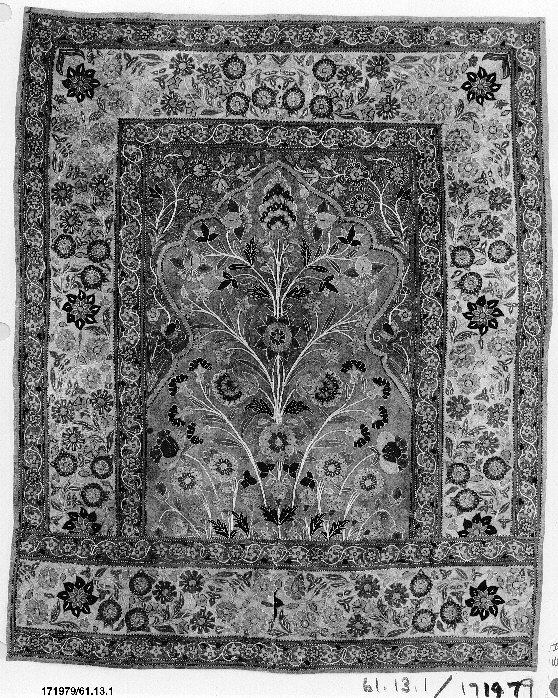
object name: panel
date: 1701-1800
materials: felt, silk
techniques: embroidery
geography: iran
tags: flowers,leaves